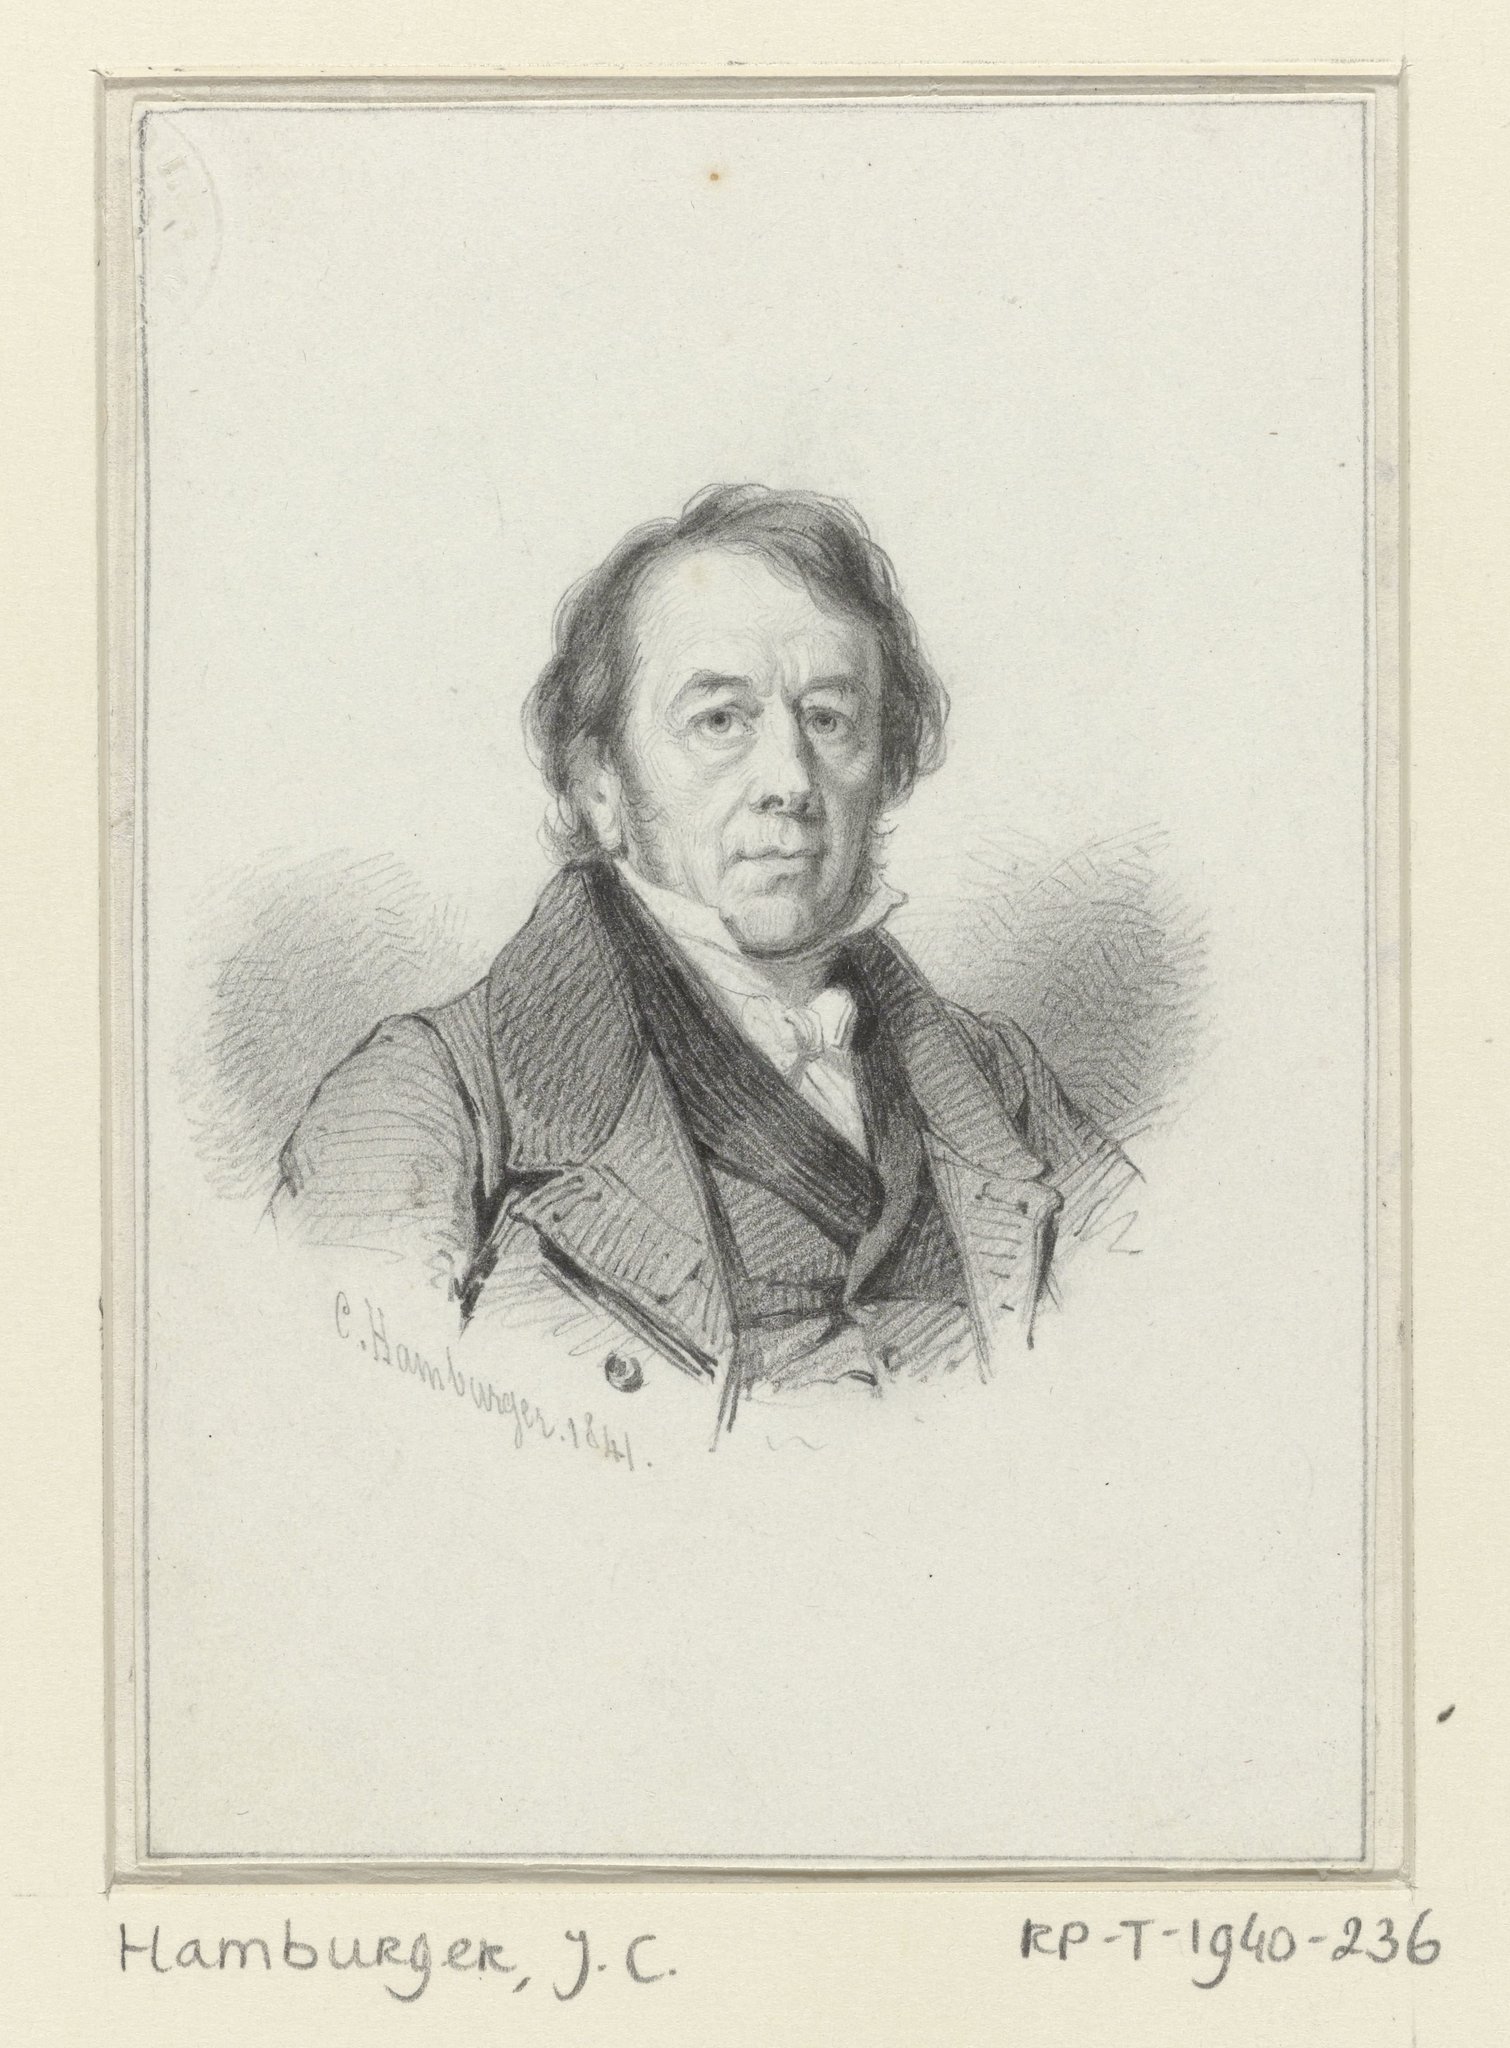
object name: drawing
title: Portret van Louis Moritz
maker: coenraad hamburger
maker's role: draughtsman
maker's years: 1809-1891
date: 1841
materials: paper, pencil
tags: the hague, amsterdam, painter, louis moritz, historical persons, portrait, self-portrait of artist